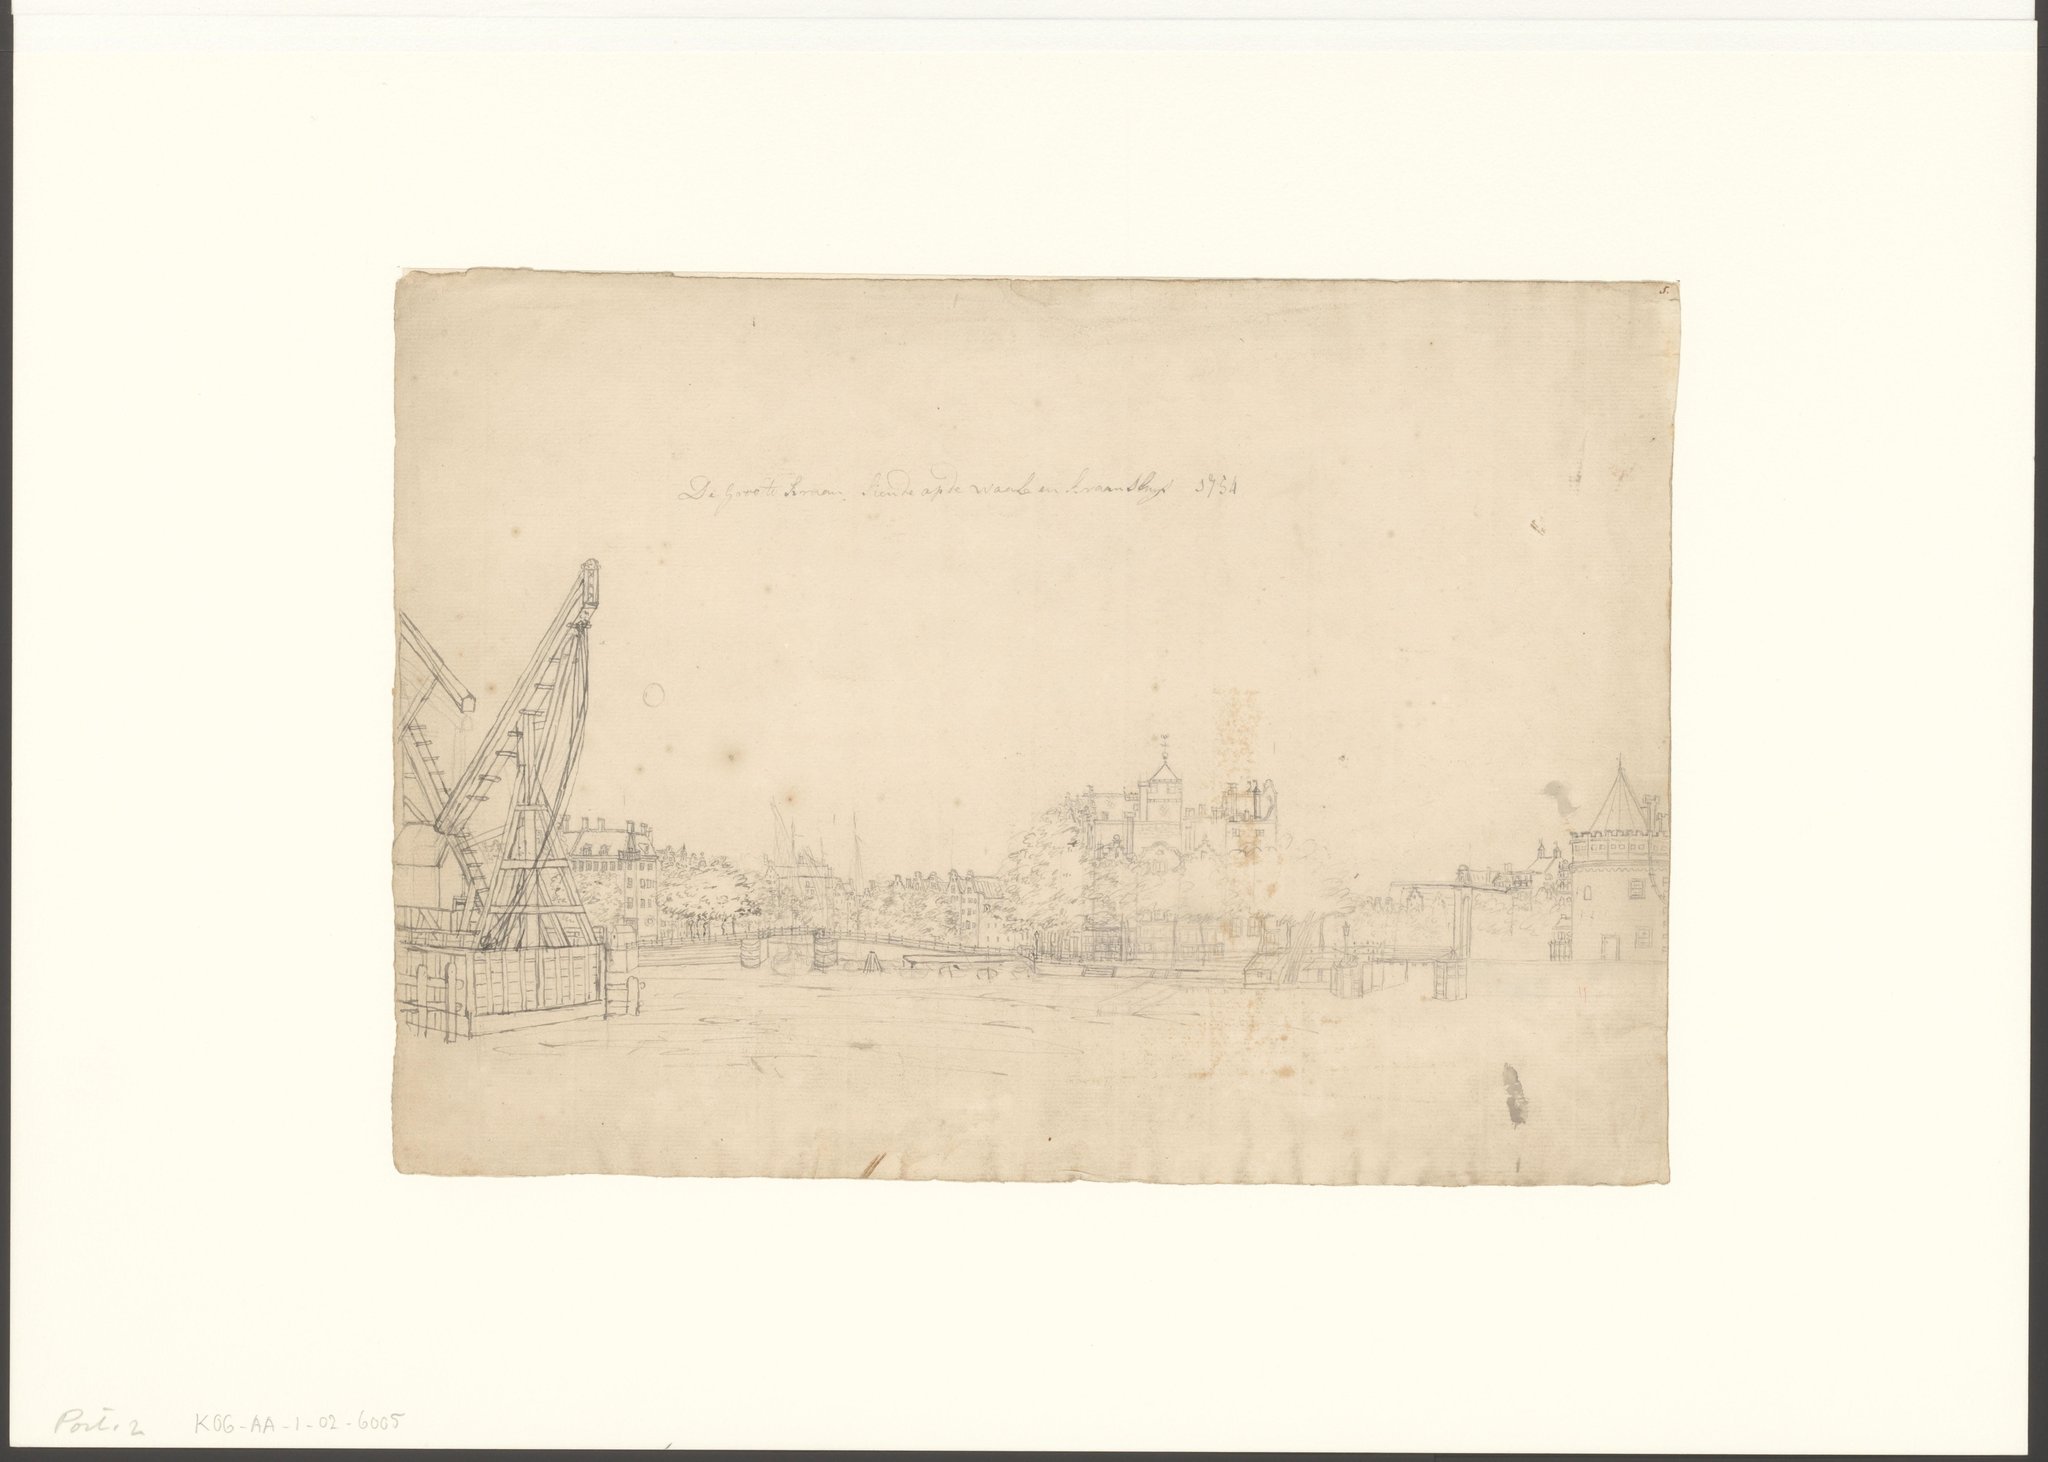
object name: drawing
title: Gezicht op de Waal en de Kraansluis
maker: jan spaan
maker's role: print maker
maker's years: 1742-1828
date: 1754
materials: ink, paper, pencil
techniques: pen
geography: amsterdam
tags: city-view in general; 'veduta', river, bridge in city across river, canal, etc., amsterdam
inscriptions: inscription: ‘De Groote kraan siende op de Waal en kraansluis’, inscription: ‘Atlas D C[...] 1918’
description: Onderwerpsrubriek binnen de Atlas Amsterdam: Gezichten van het IJ op het Oostelijk gedeelte der stad, Nieuwebrug tot Zeeburg.